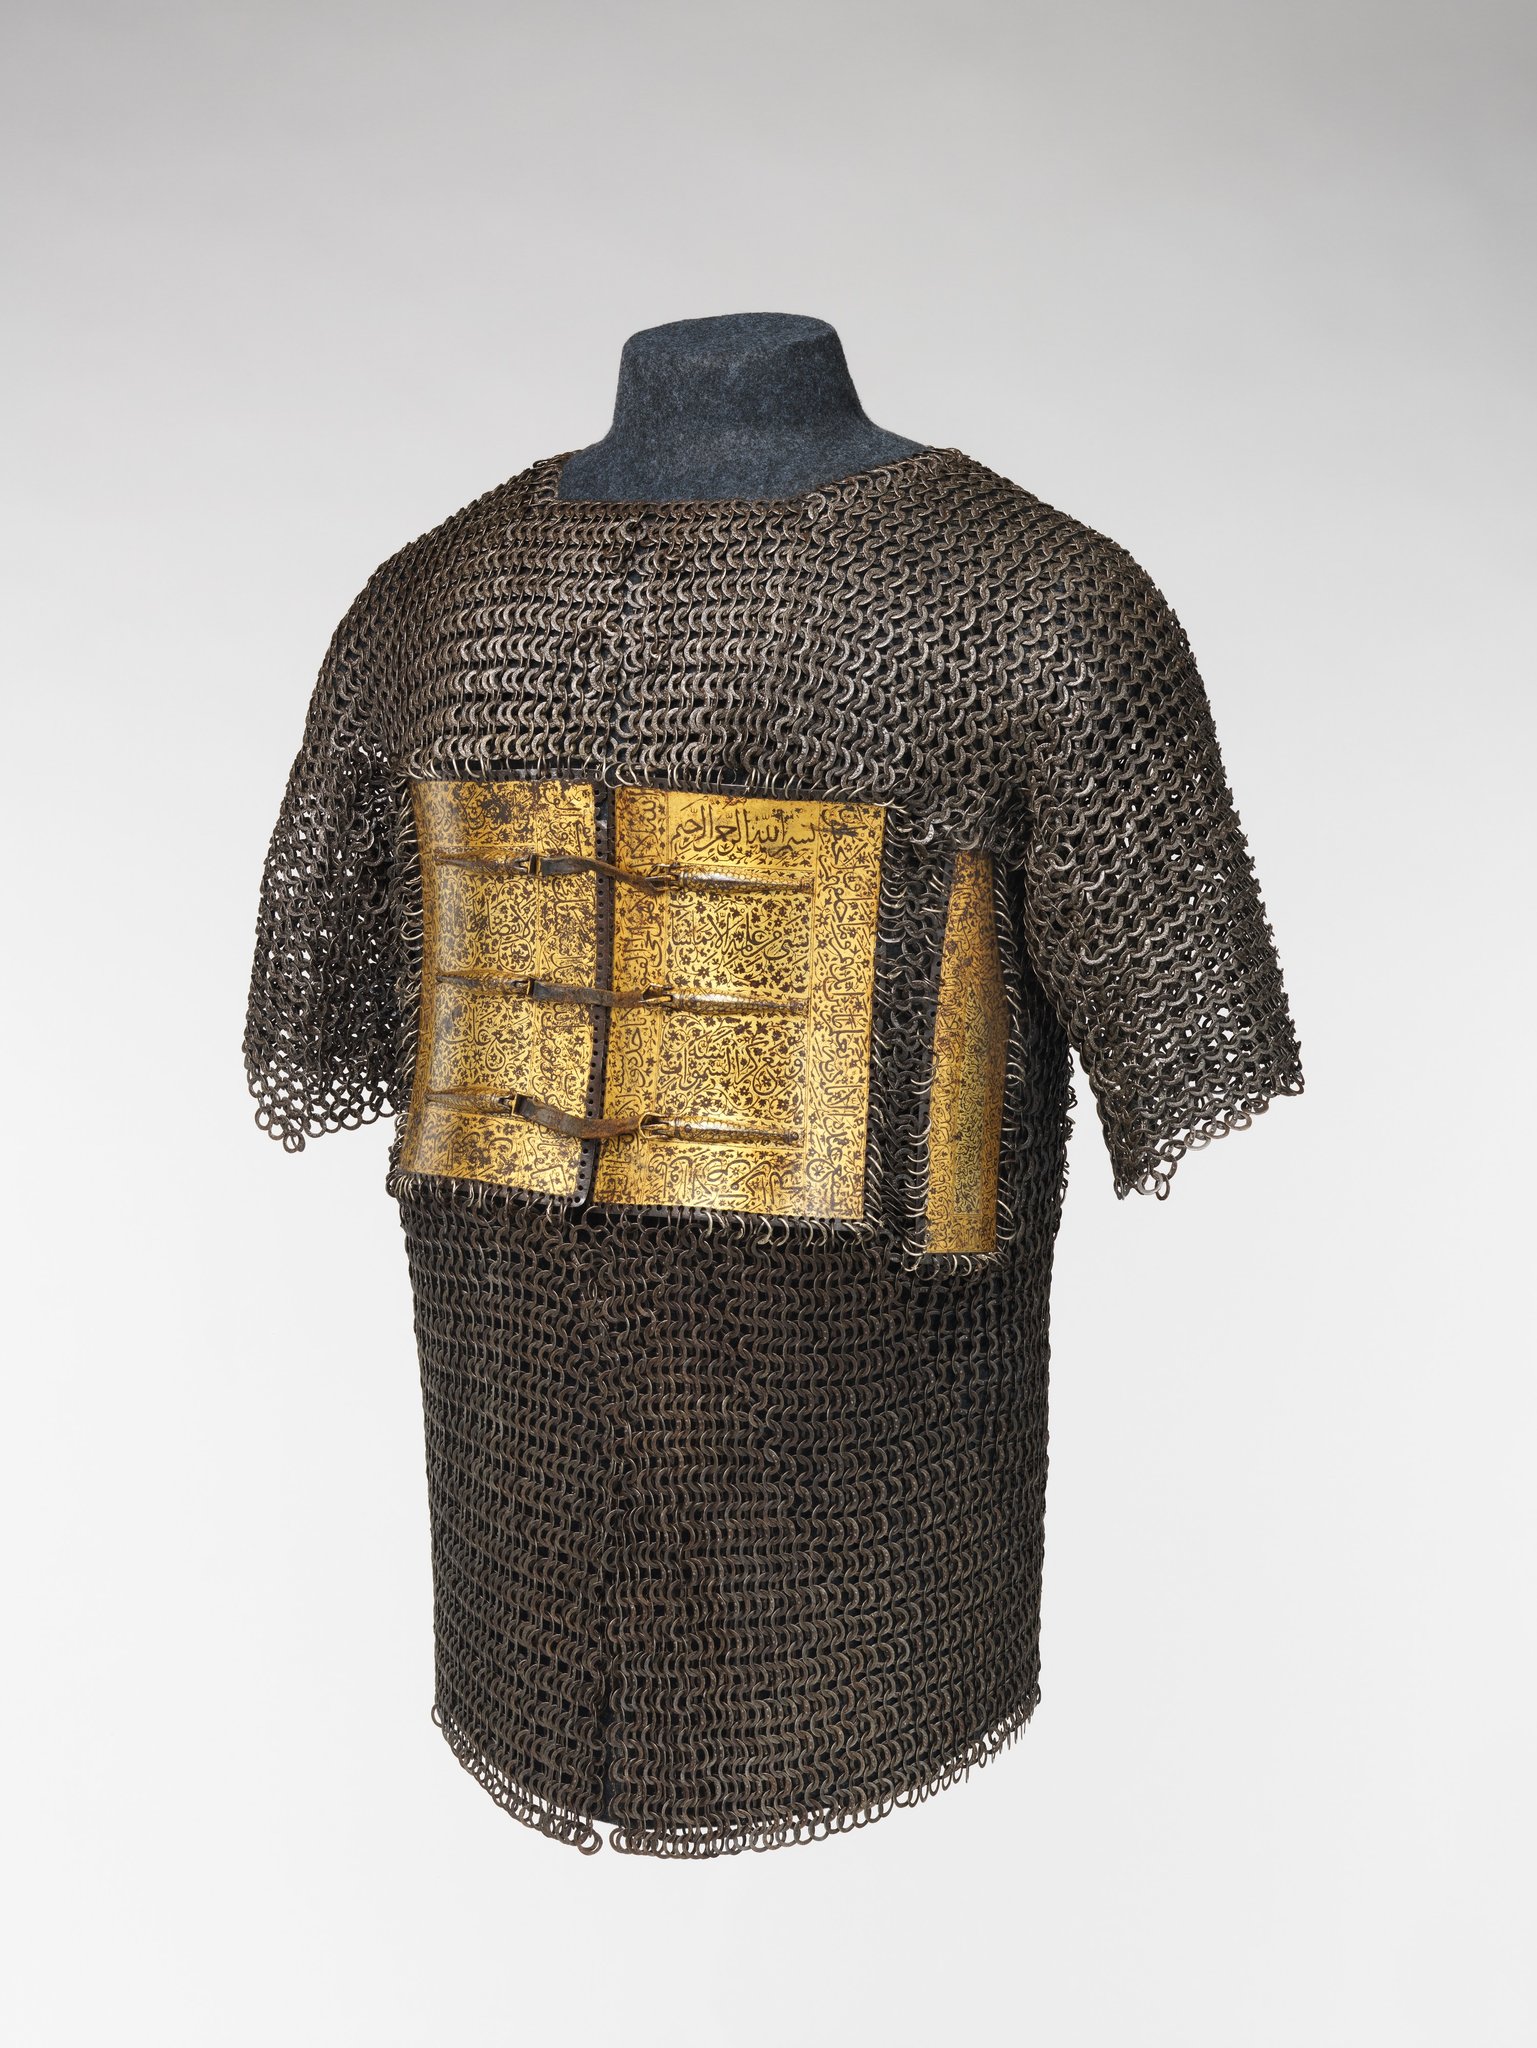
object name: shirt of mail and plate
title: Shirt of Mail and Plate of Emperor Shah Jahan (reigned 1624–58)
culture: indian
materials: gold, iron, leather, steel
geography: india